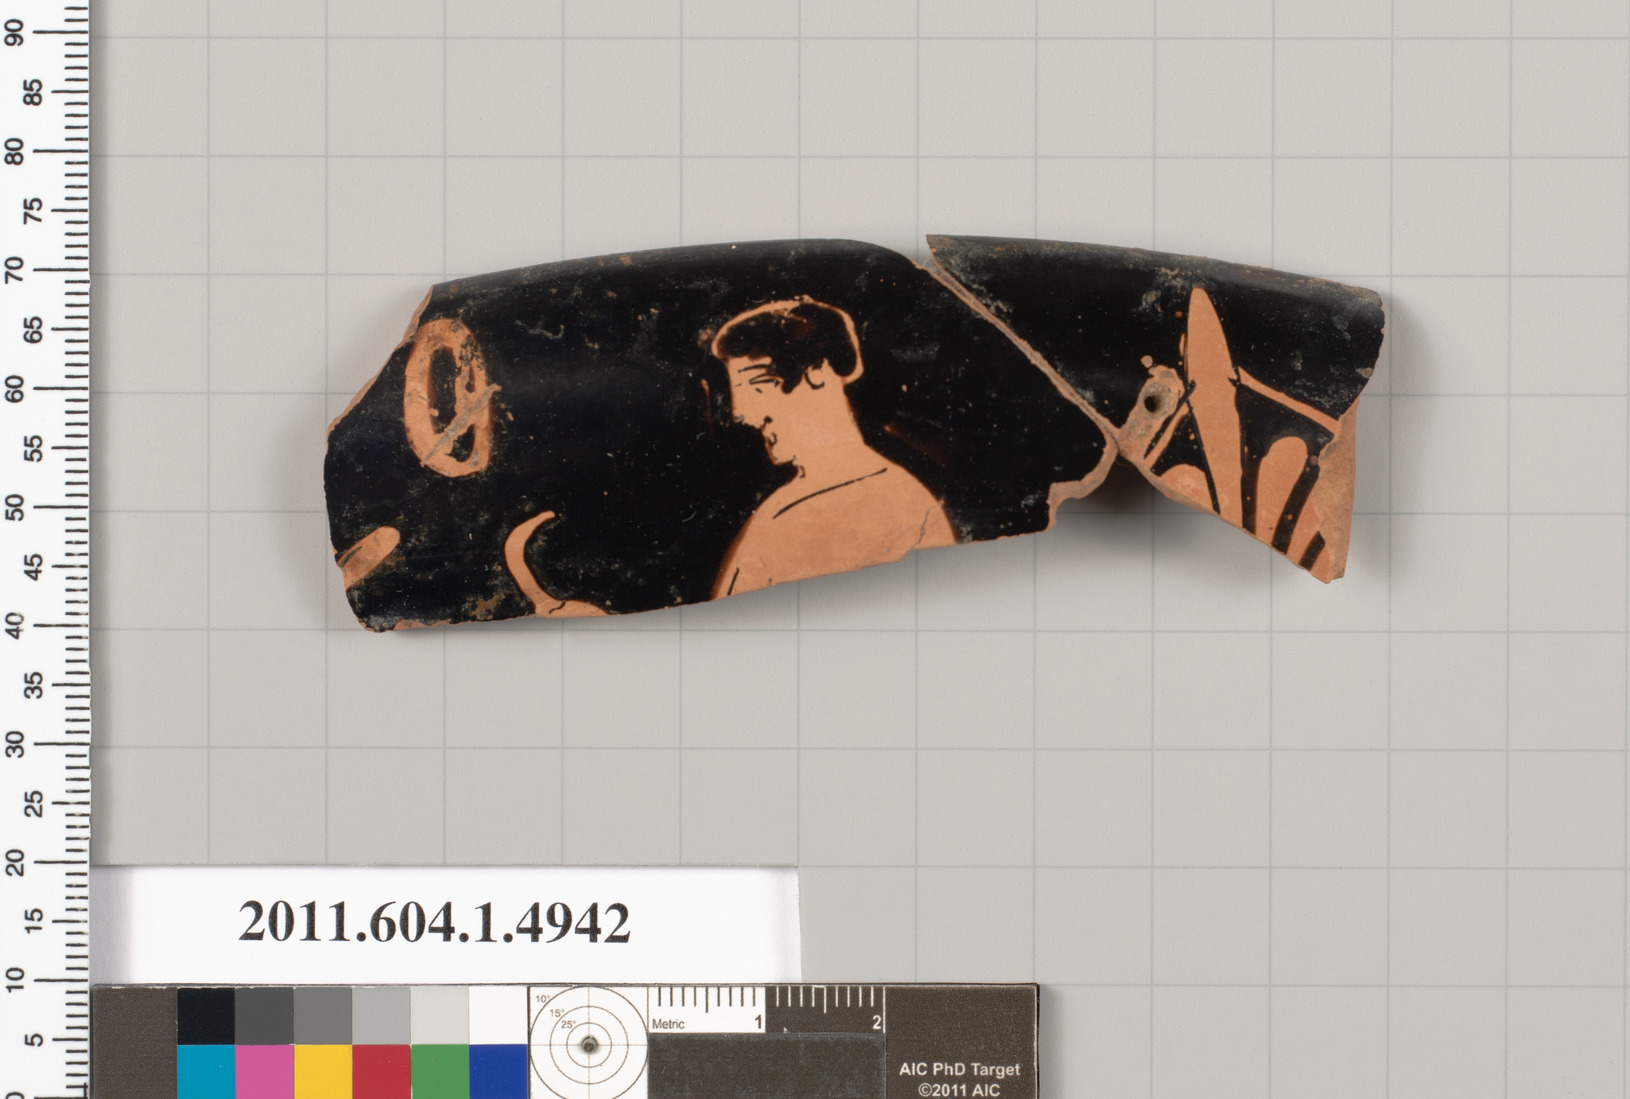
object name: kylix fragment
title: Terracotta rim fragment of a kylix (drinking cup)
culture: greek, attic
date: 460-450 BCE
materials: terracotta